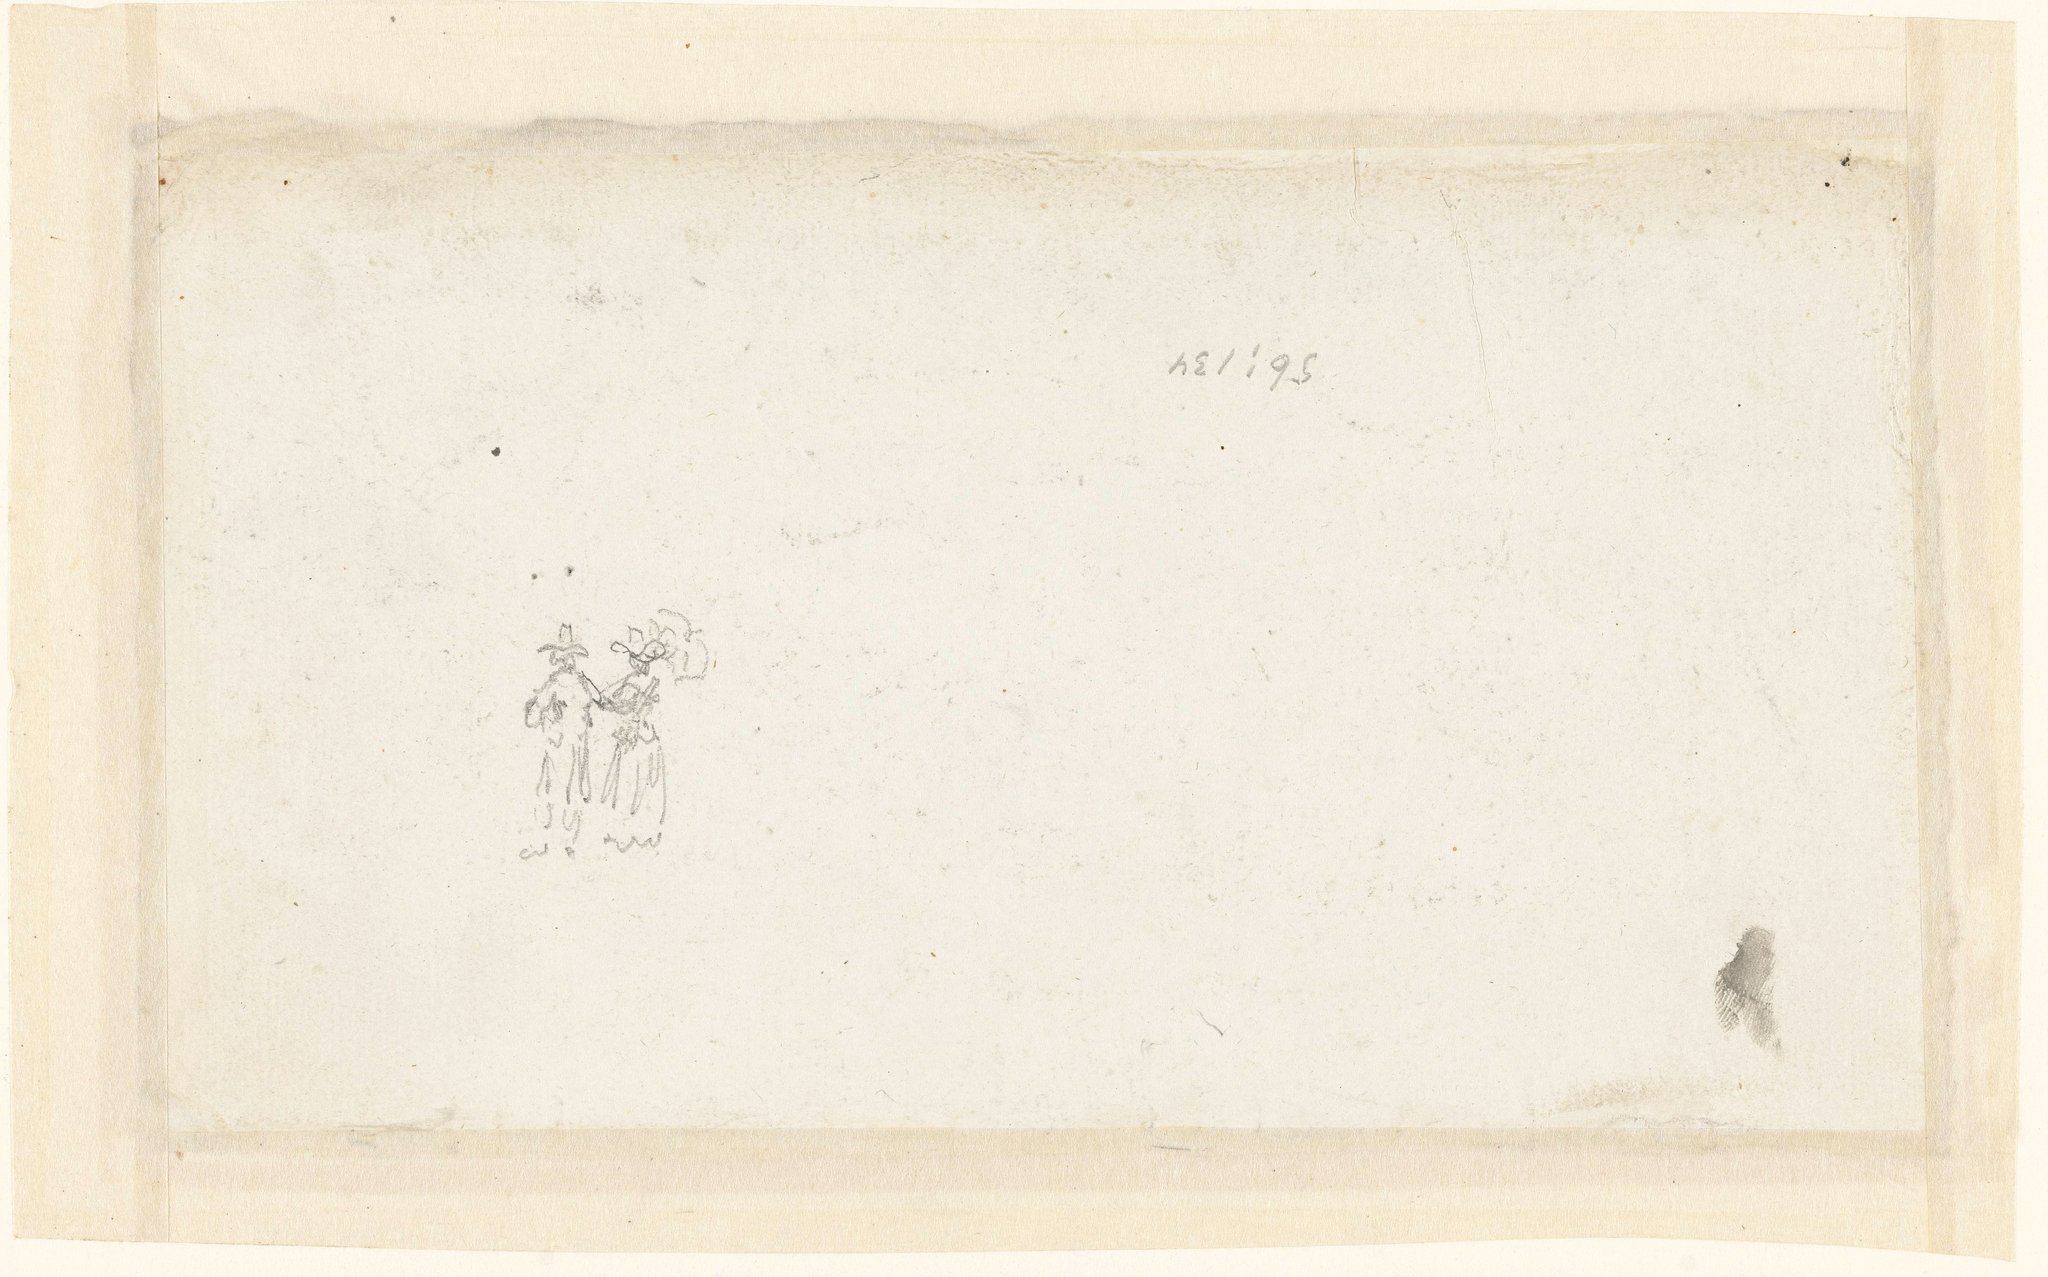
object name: drawing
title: Man met een hoed en een vrouw met een hoed en parasol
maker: david alphonse de sandoz-rollin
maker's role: draughtsman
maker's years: 1740-1809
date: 1750-1809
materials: paper, pencil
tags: walking, parasol, sunshade